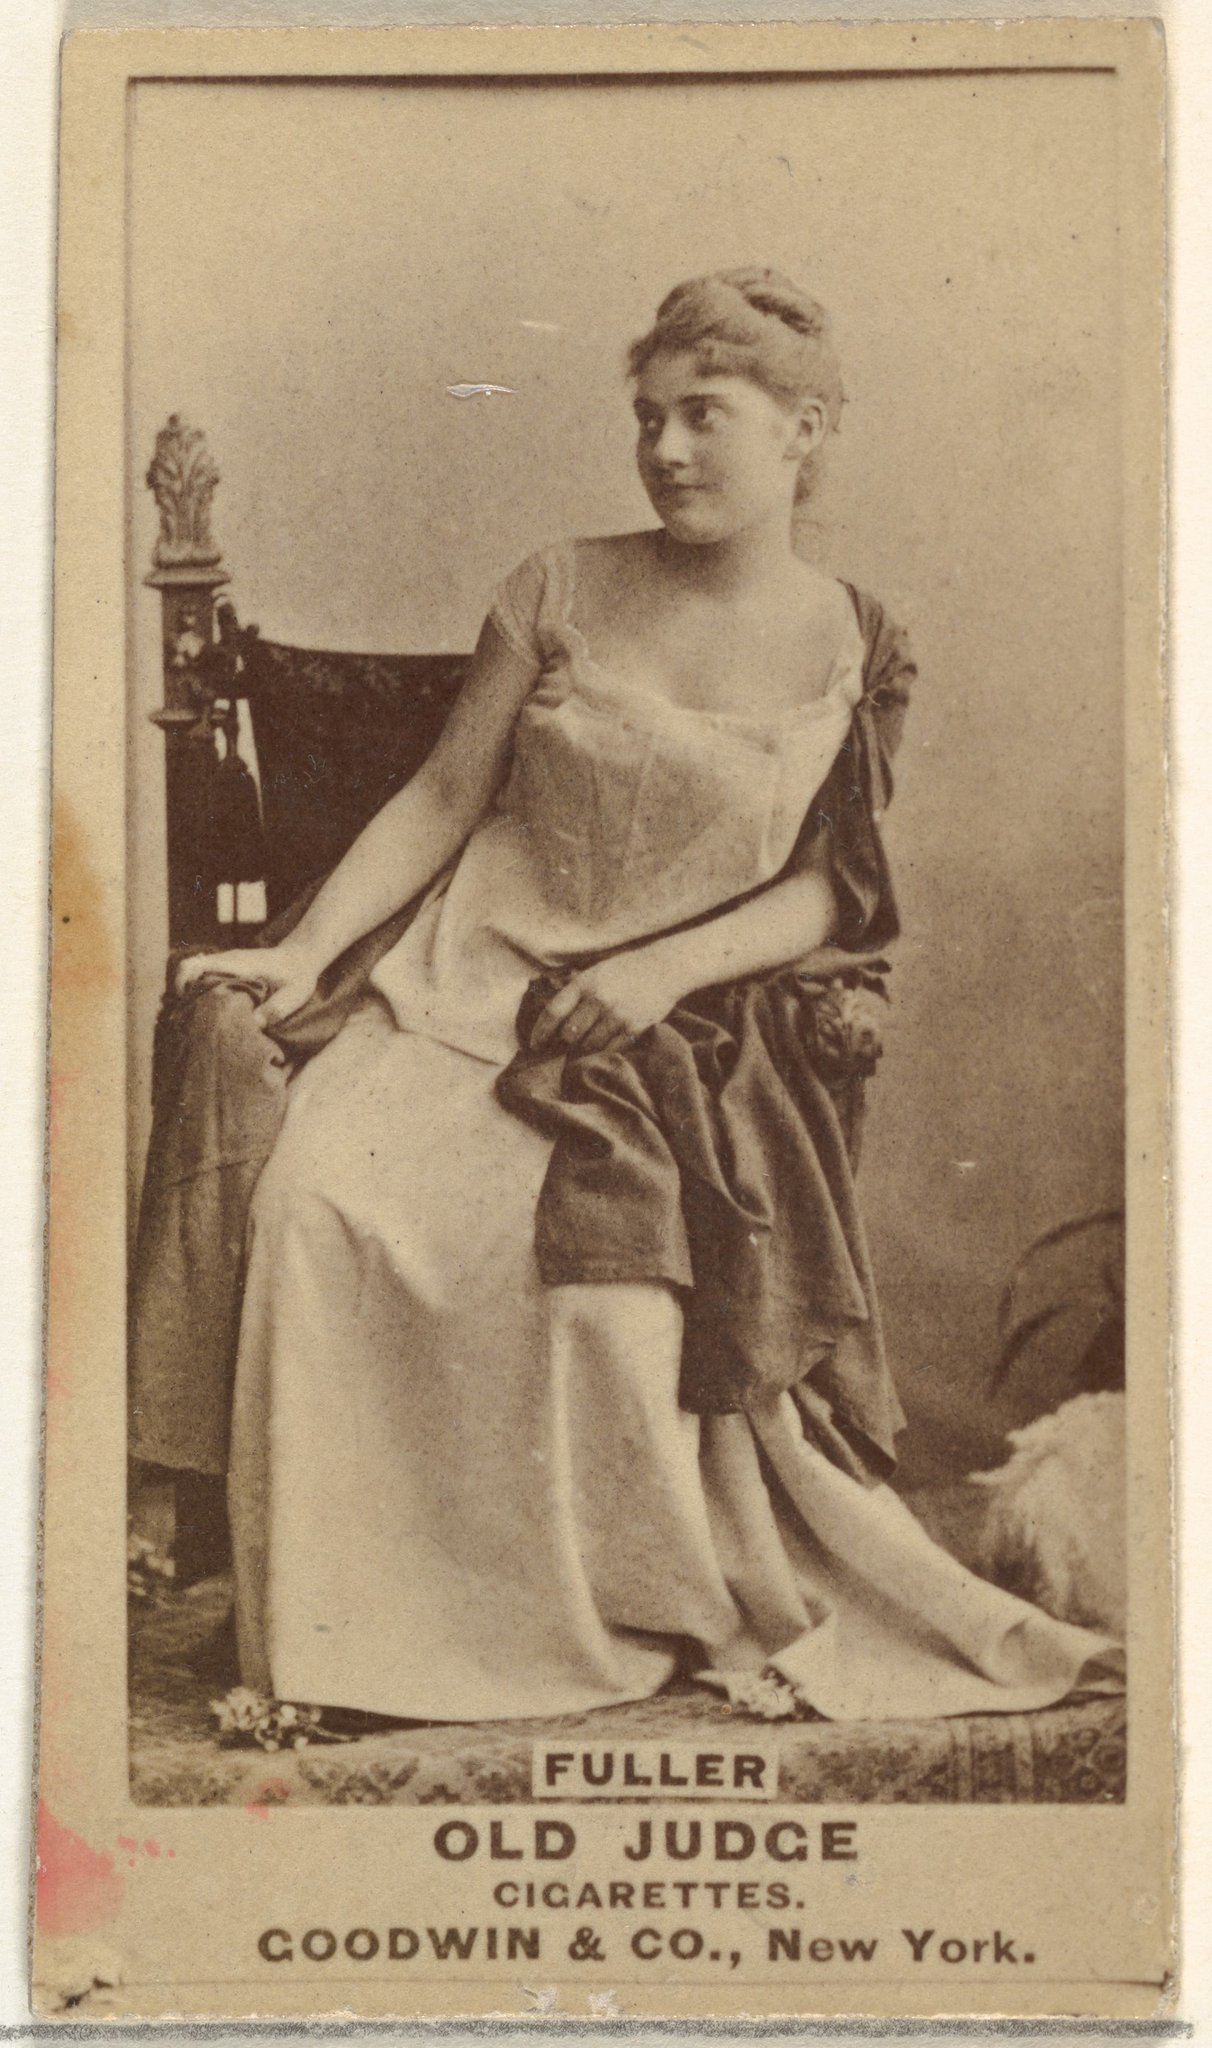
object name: photograph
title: Fuller, from the Actors and Actresses series (N171) for Old Judge Cigarettes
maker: goodwin & company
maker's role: publisher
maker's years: 1850-1950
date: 1886-1890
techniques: albumen silver print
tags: portraits,women,actresses